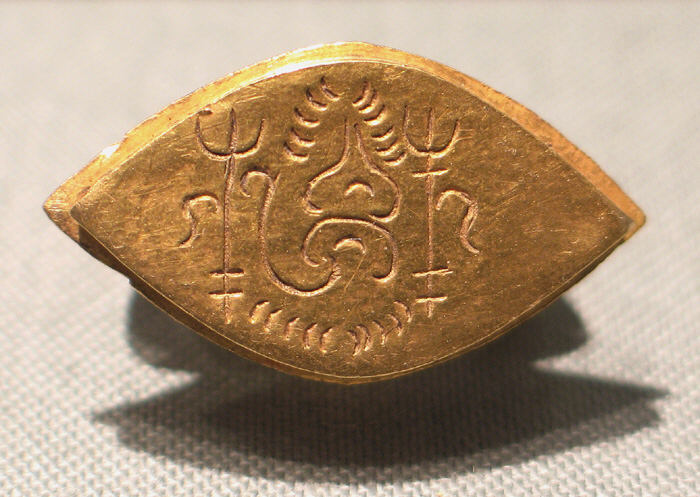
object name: ring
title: Stirrup-Shaped Ring with Oblong Bezel and Conch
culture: indonesian, javanese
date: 701-933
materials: gold